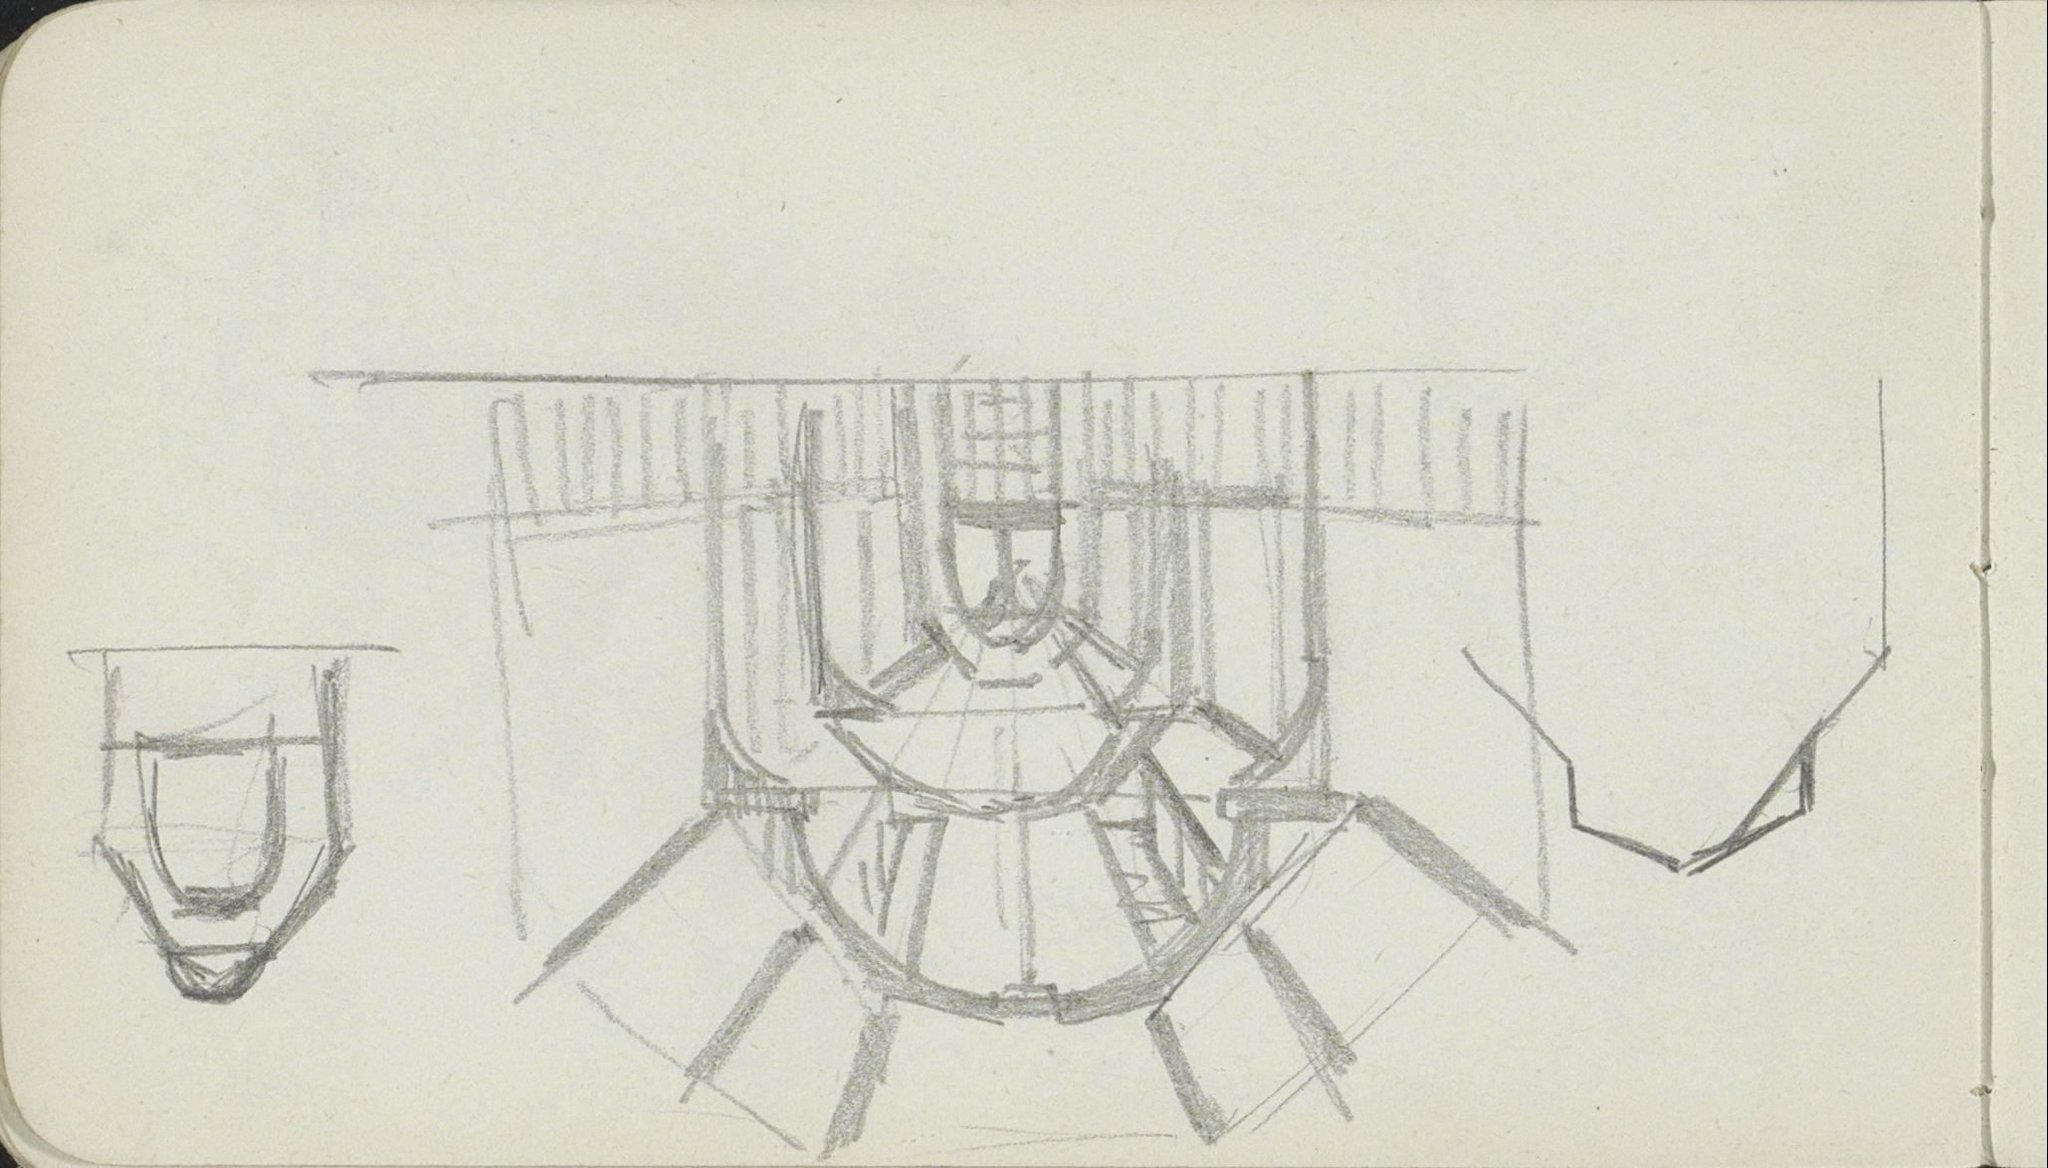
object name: sketchbook leaf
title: Gewelf in een kerkinterieur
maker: carel adolph lion cachet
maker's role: draughtsman, print maker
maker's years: 1864-1945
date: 1905-1906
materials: paper, pencil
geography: vreeland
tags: parts of church interior: vault, interior of church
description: Blad 16 verso uit een schetsboek met 34 bladen.